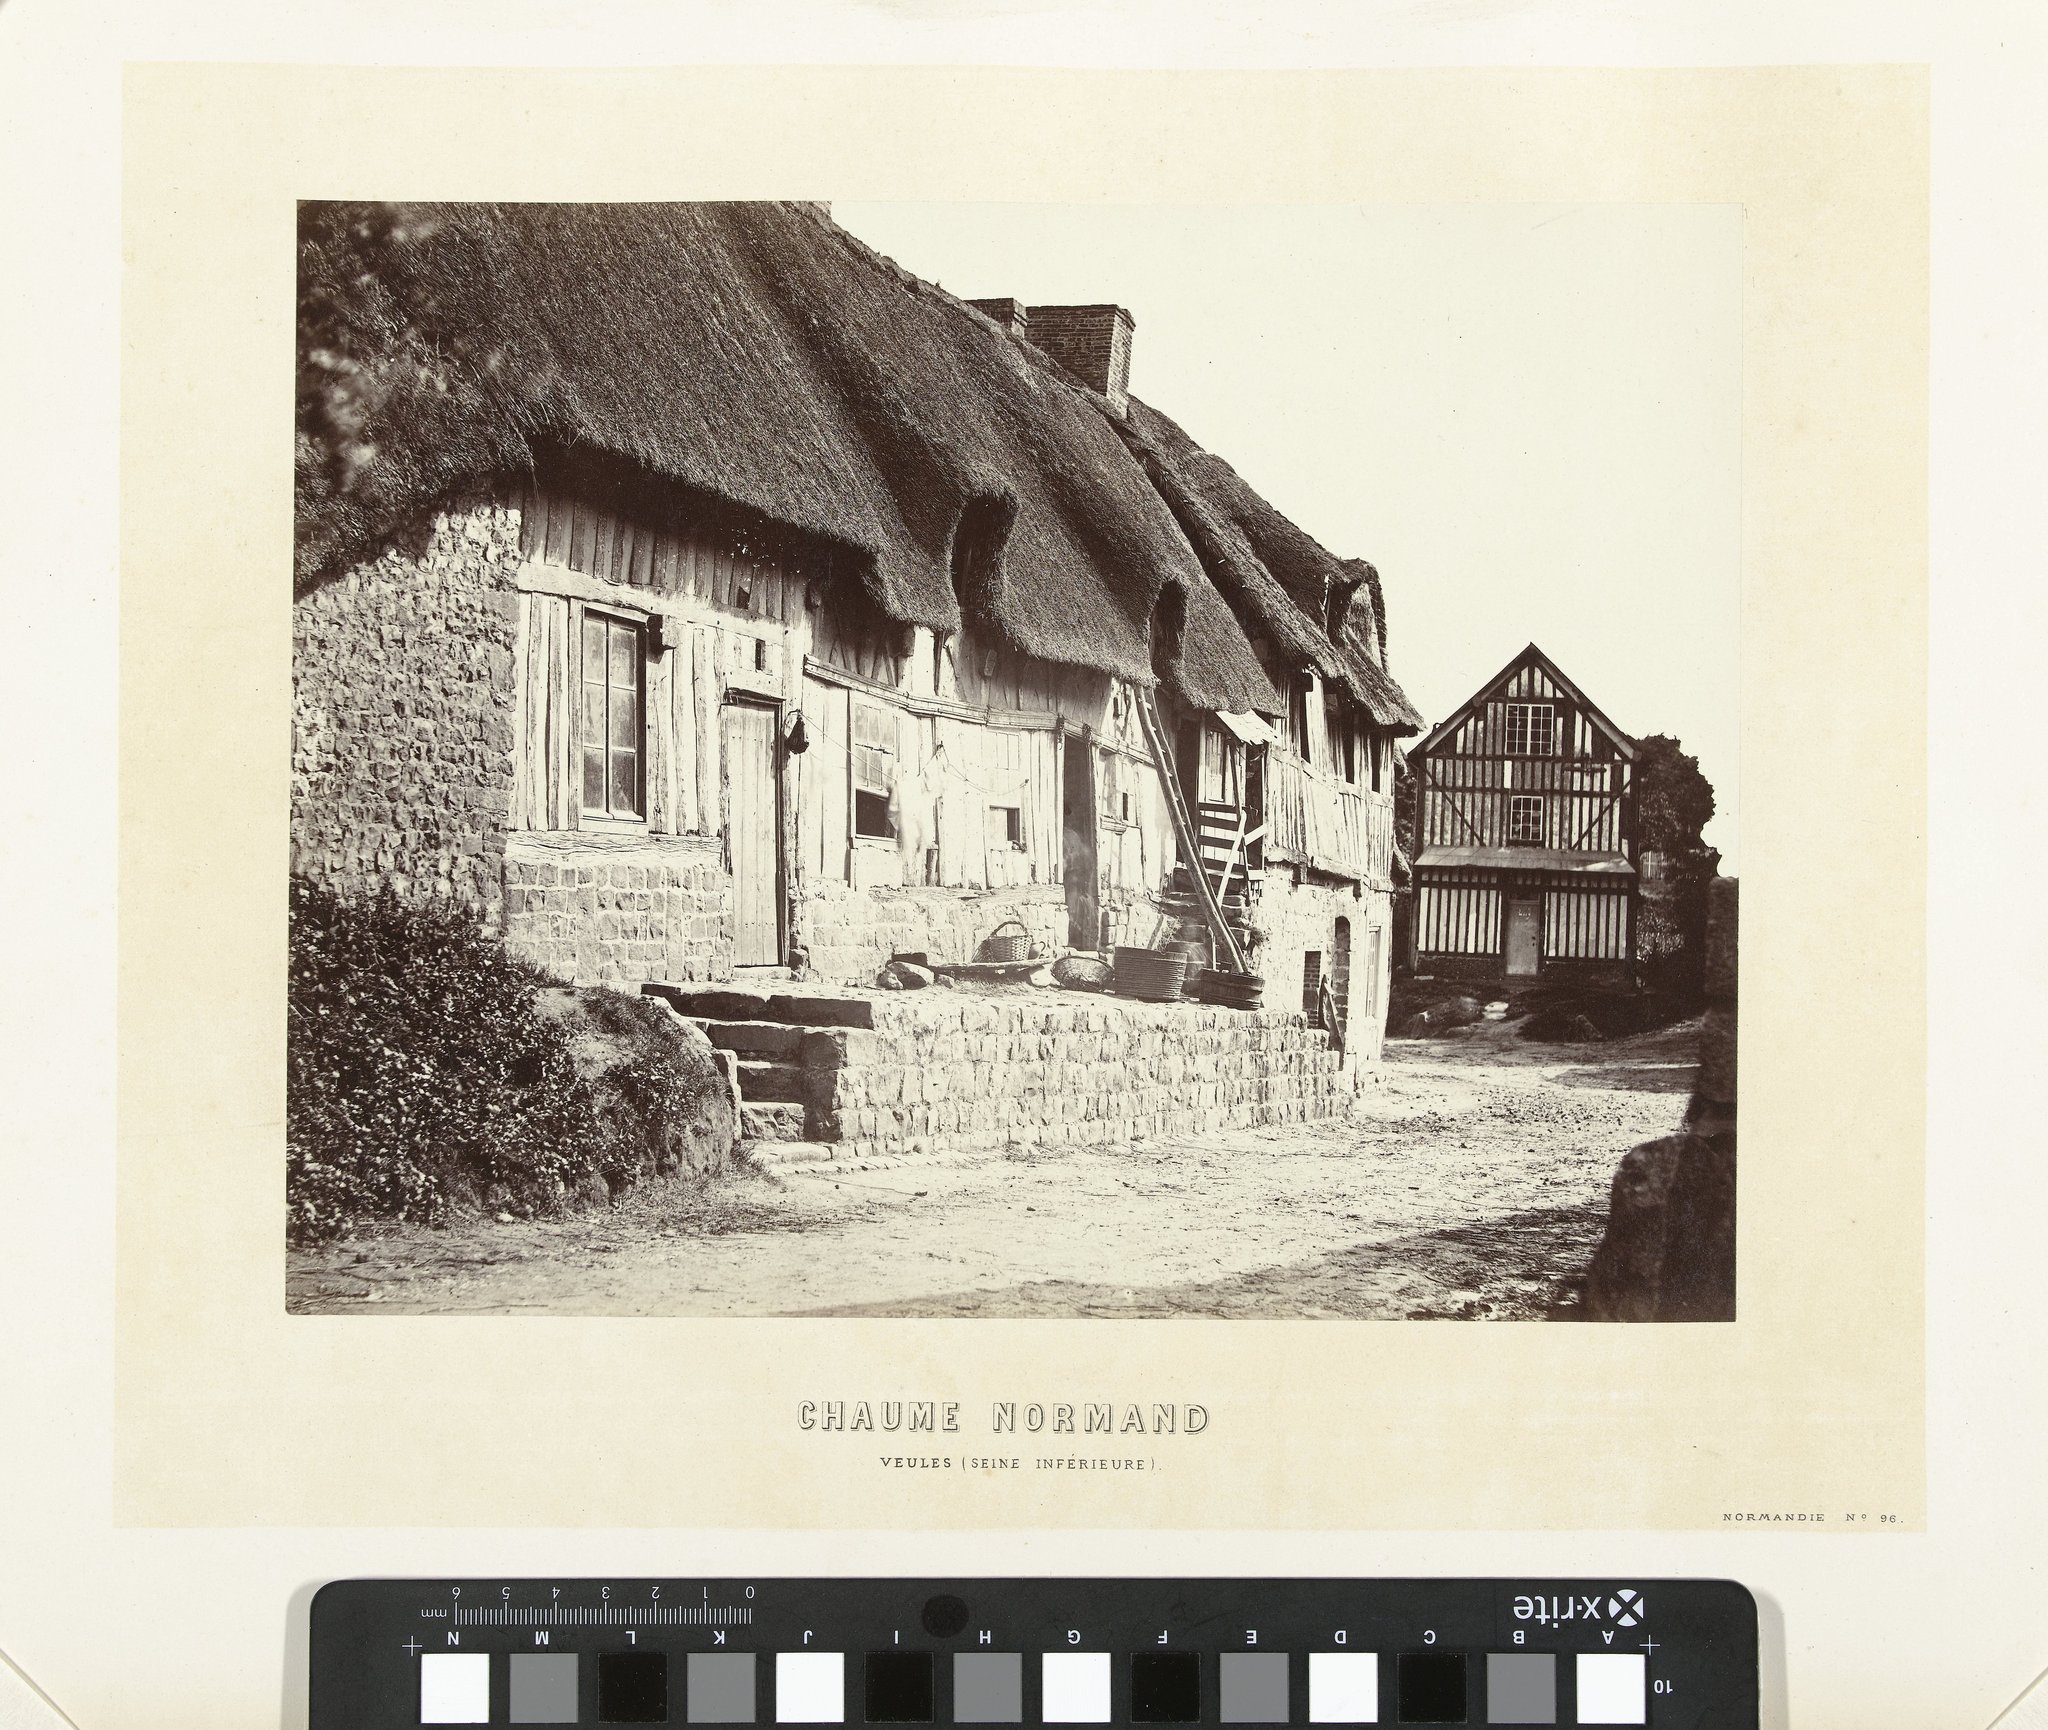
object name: photograph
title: Huis met rieten dak in Veules (bij Dieppe)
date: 1860-1870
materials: cardboard, paper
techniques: albumen print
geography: veules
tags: rural housing, e.g. country-house, villa, cottage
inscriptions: signature: ‘Panhard Frères/ aout 1865’, number: ‘No. 96’